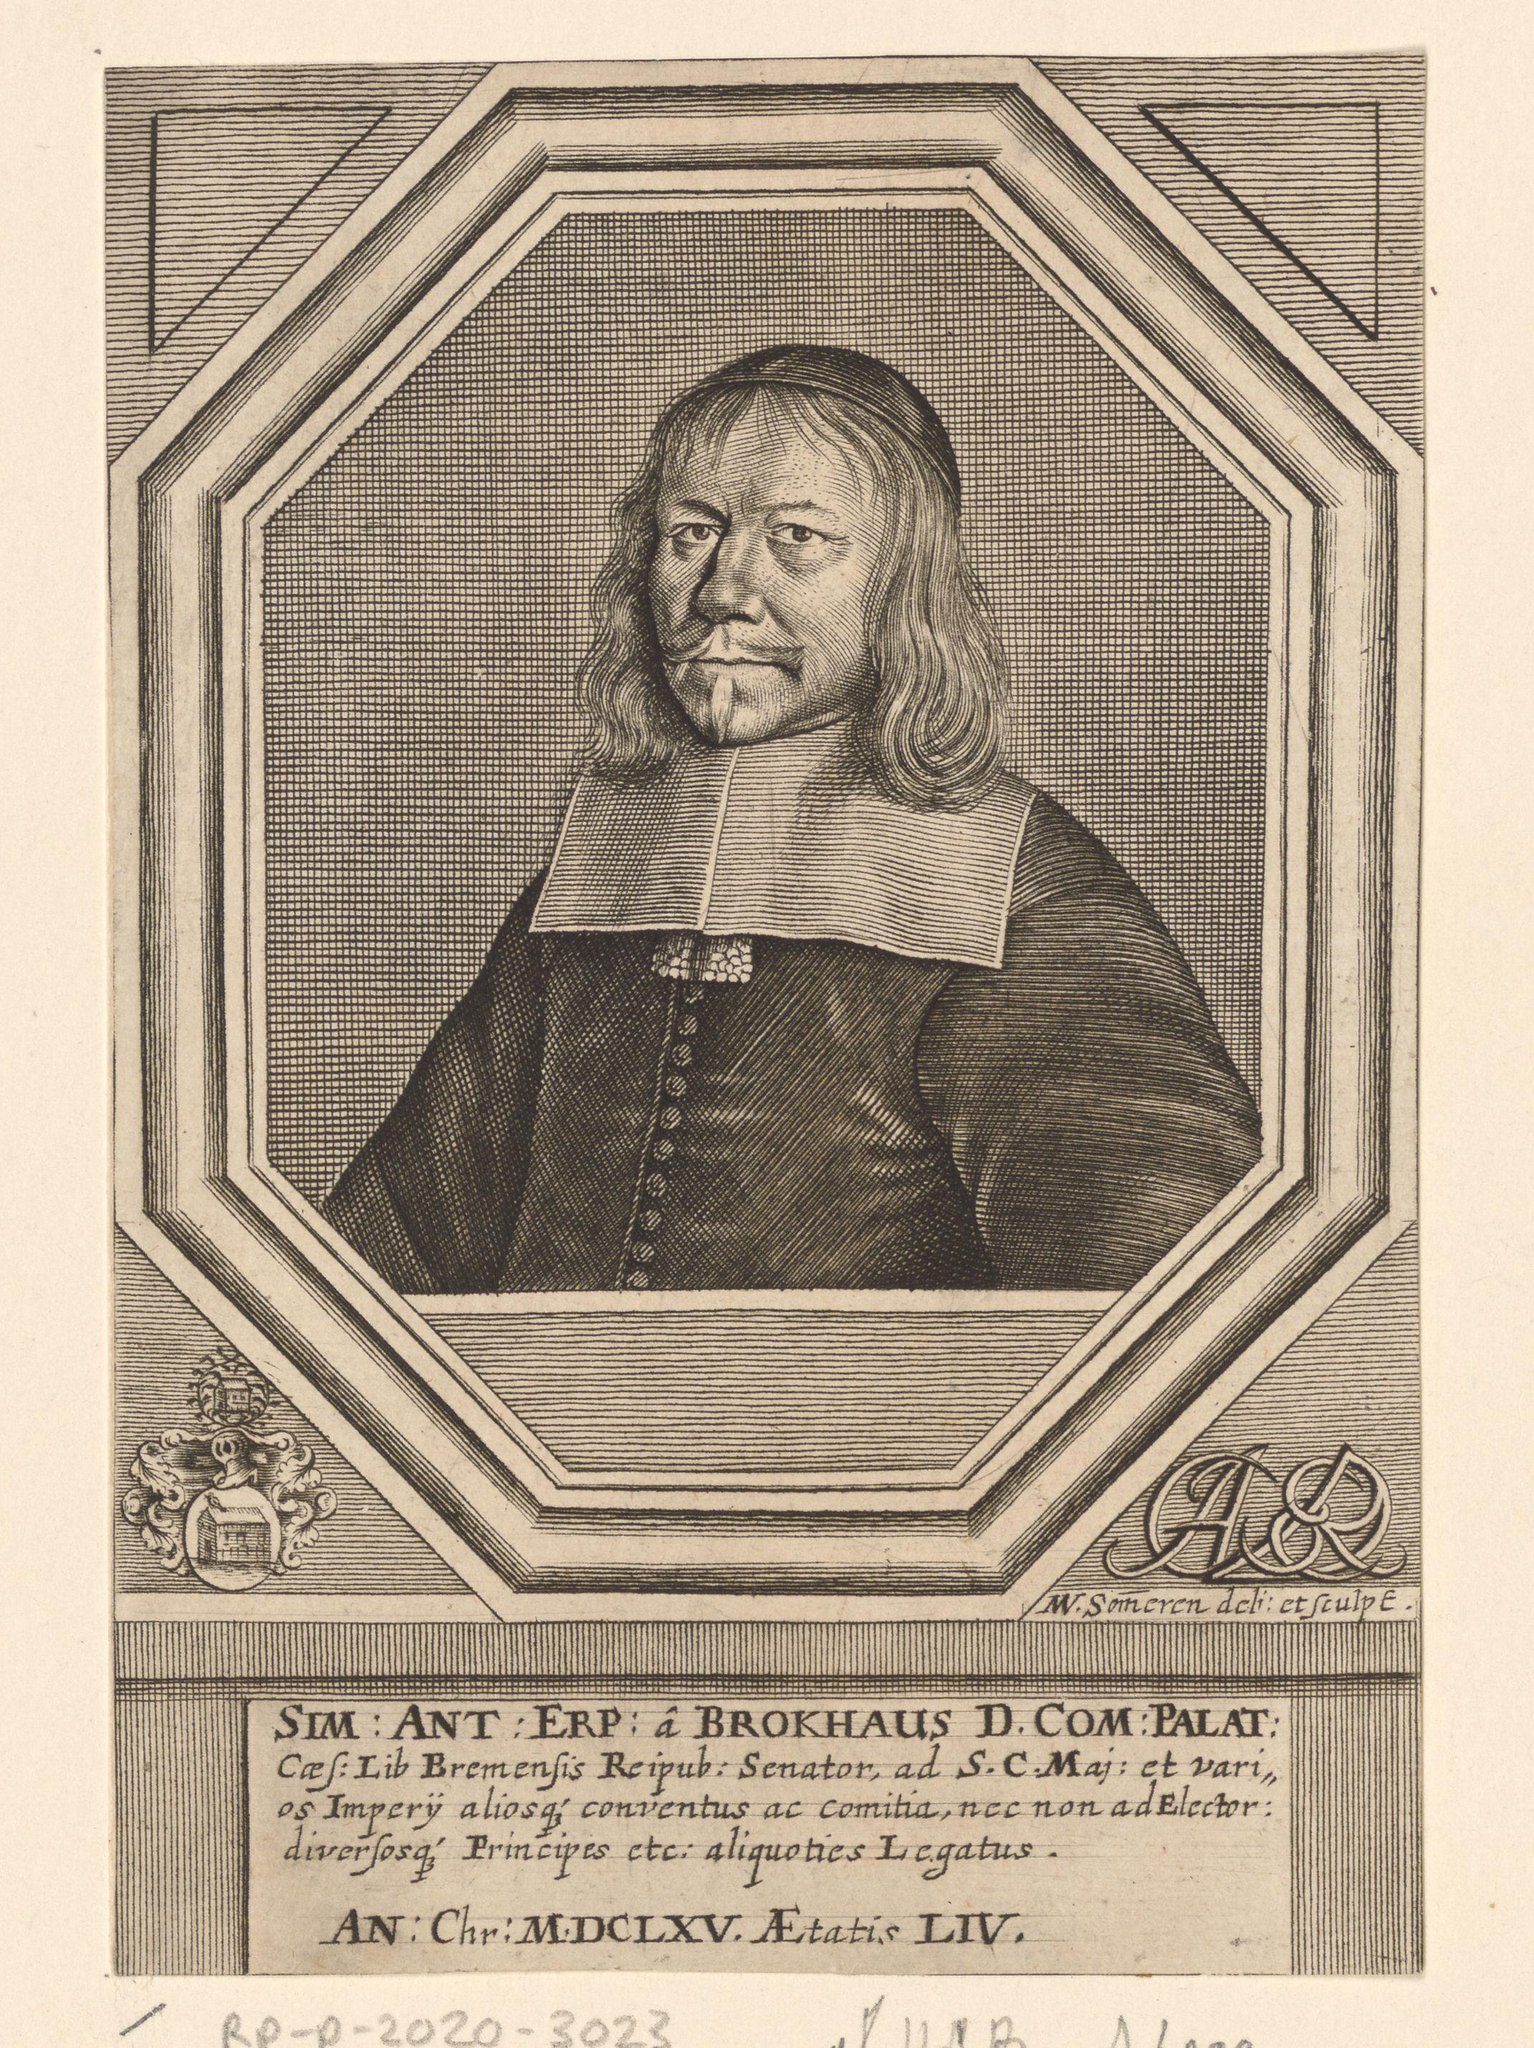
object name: book illustration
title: Portret van Simon Anton Erp-Brockhausen op 54-jarige leeftijd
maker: matthias van sommer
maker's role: draughtsman, print maker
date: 1667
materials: paper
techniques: engraving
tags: historical persons, armorial bearing, heraldry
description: Prent waarschijnlijk uit: [Somer, Matthias van]. Hasce omnium electorum principum ac statuum Sacri Romani Imperii ad comitia praesentia legatis ac deputatis icones (…). Regensburg: [Matthias van Somer], 1667.